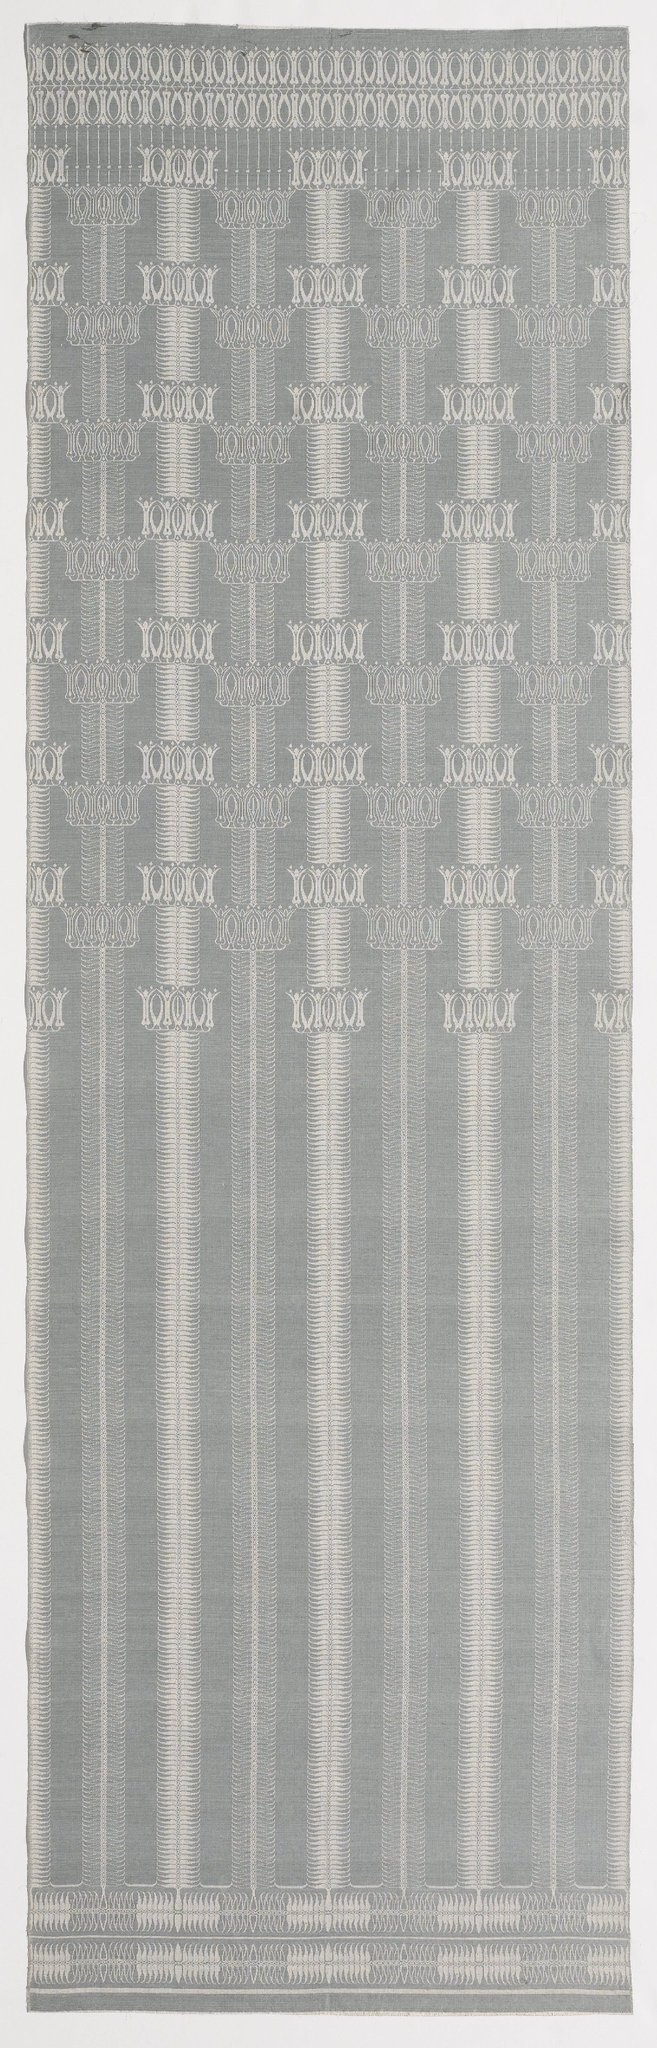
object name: upholstered wall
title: Fabric Coverings with Patterns of Gillyflowers and Water Lilies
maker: chris lebeau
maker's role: draughtsman, print maker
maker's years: 1878-1945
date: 1911-1915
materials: linen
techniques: damask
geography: eindhoven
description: These decorative panels of fabric were used in well-to-do circles to cover the walls of the sitting room. The Amsterdam designer Chris Lebeau designed patterns inspired by nature, including leaves and calyces. He spread them over the surface of the fabric in a strict rhythmic order.